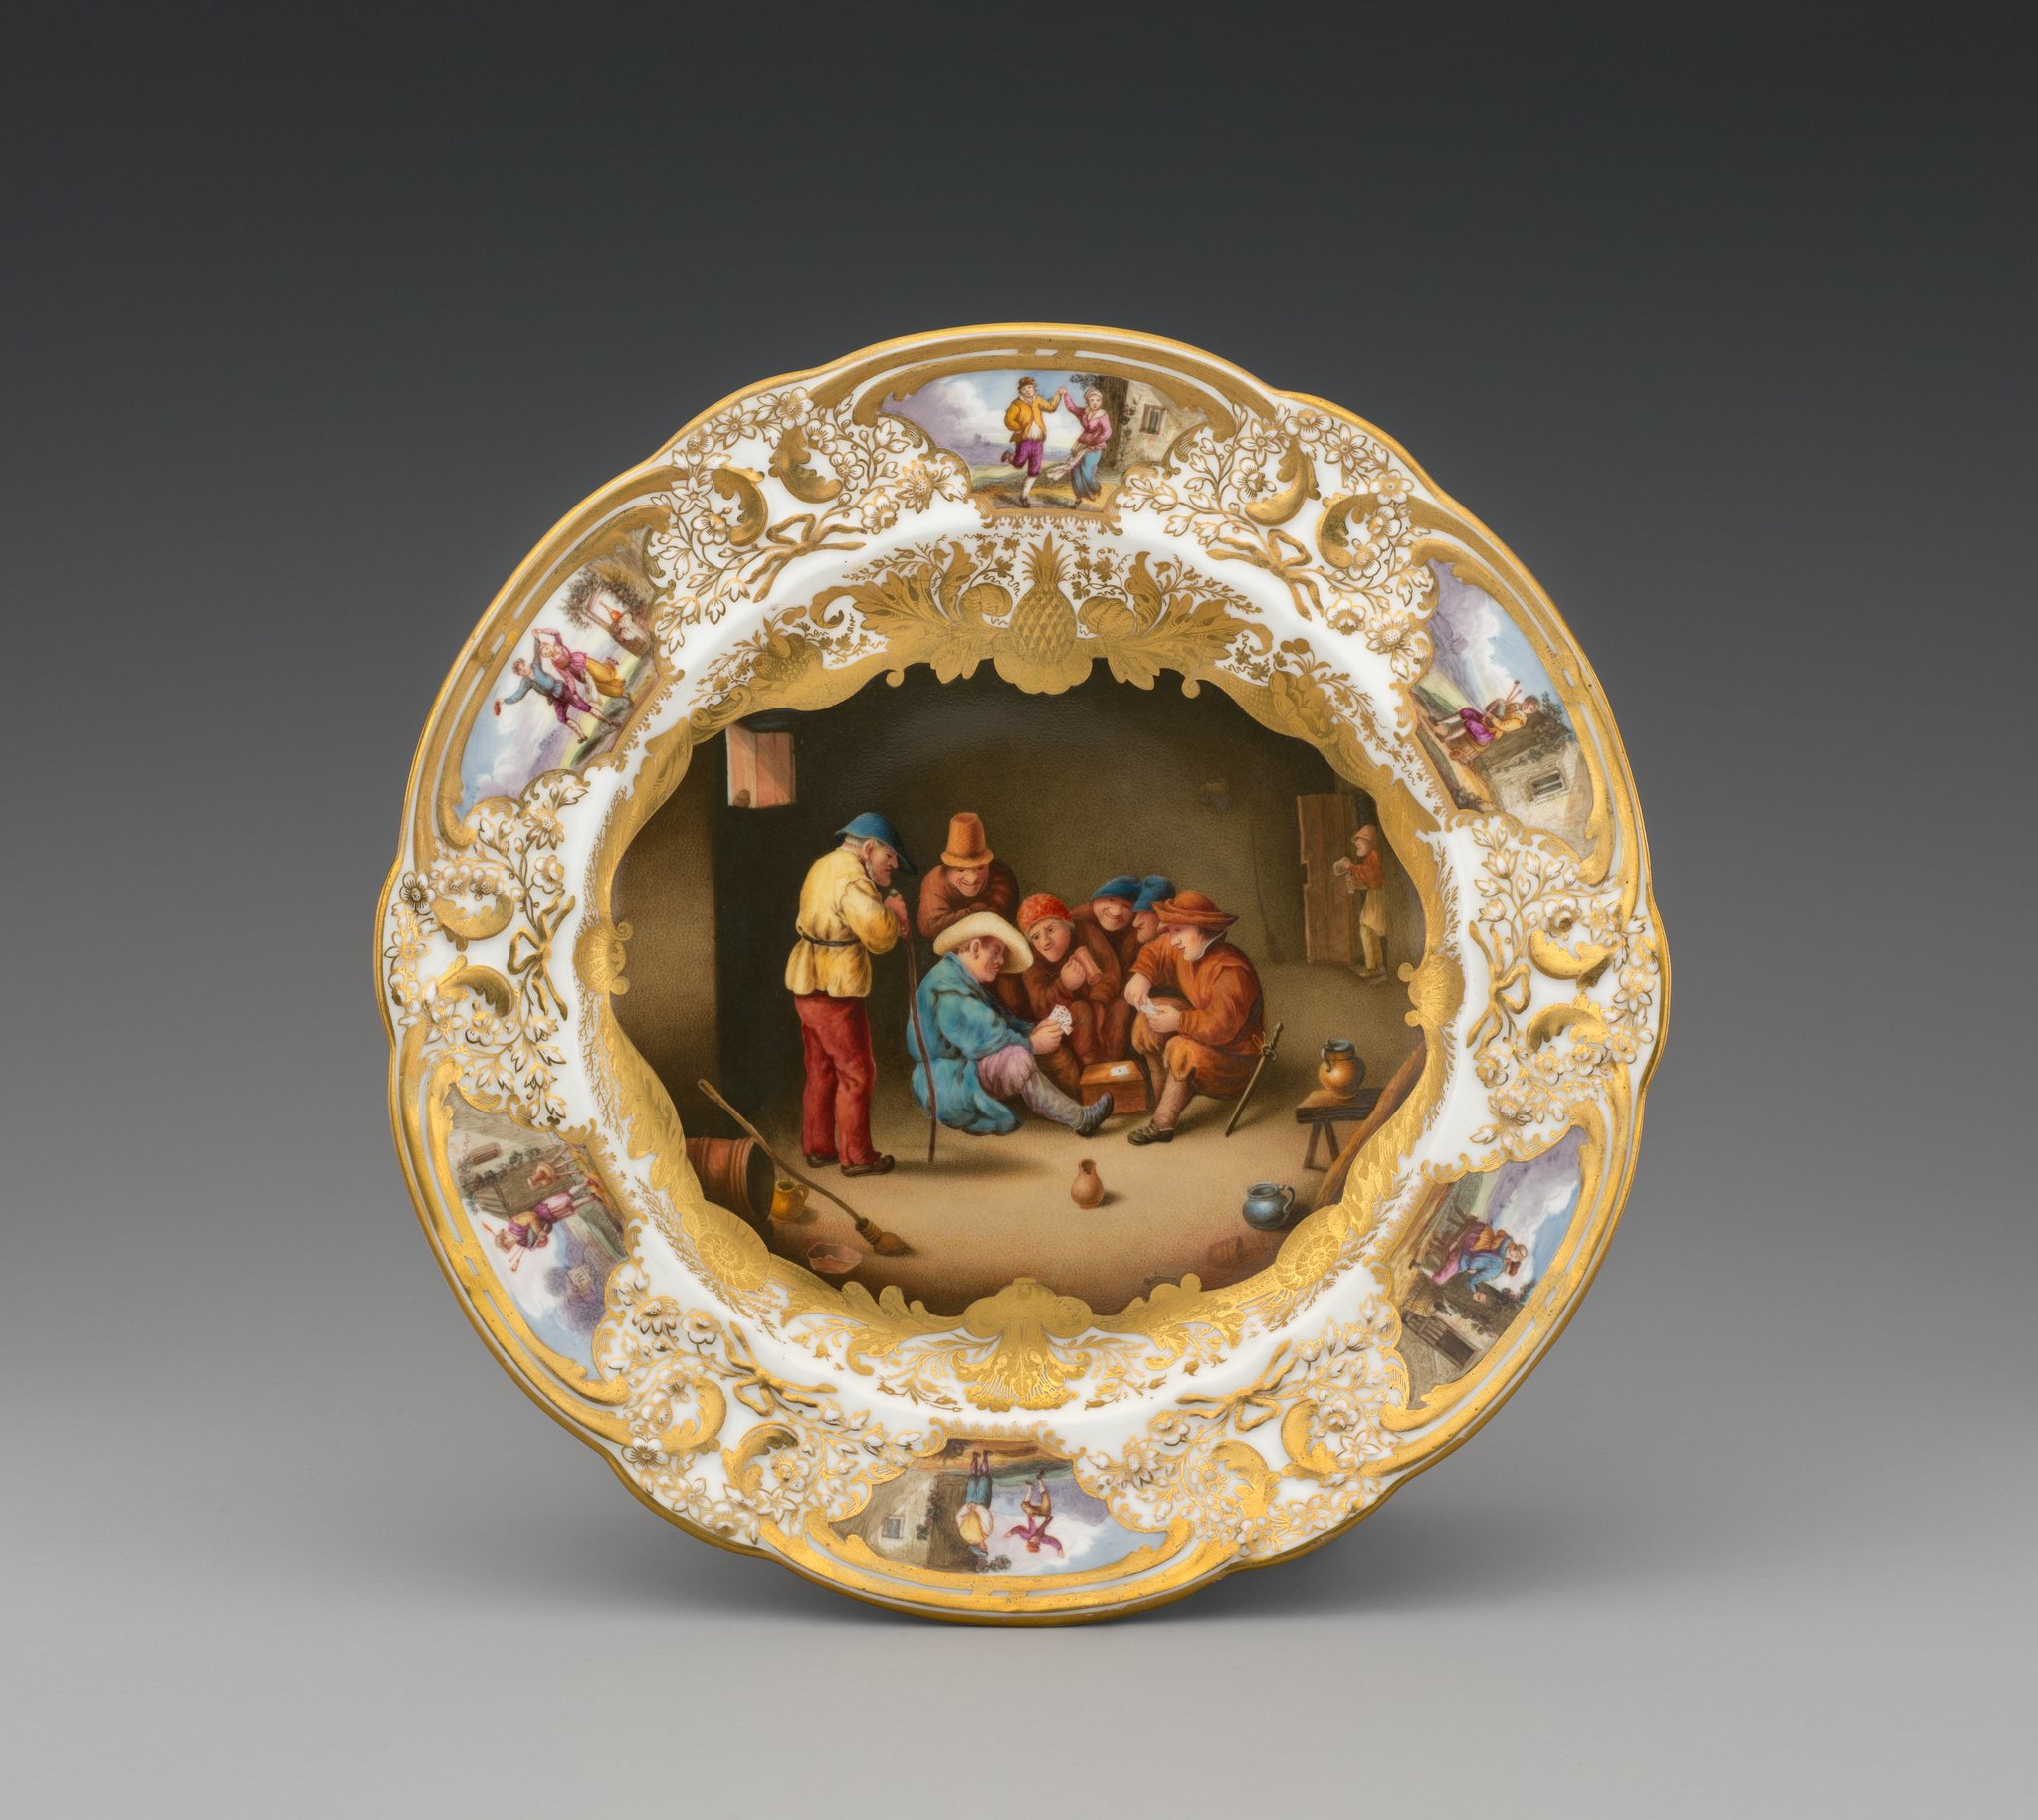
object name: plate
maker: james plant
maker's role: decorator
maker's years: 1775-1875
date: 1820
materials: soft paste porcelain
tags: men,playing cards